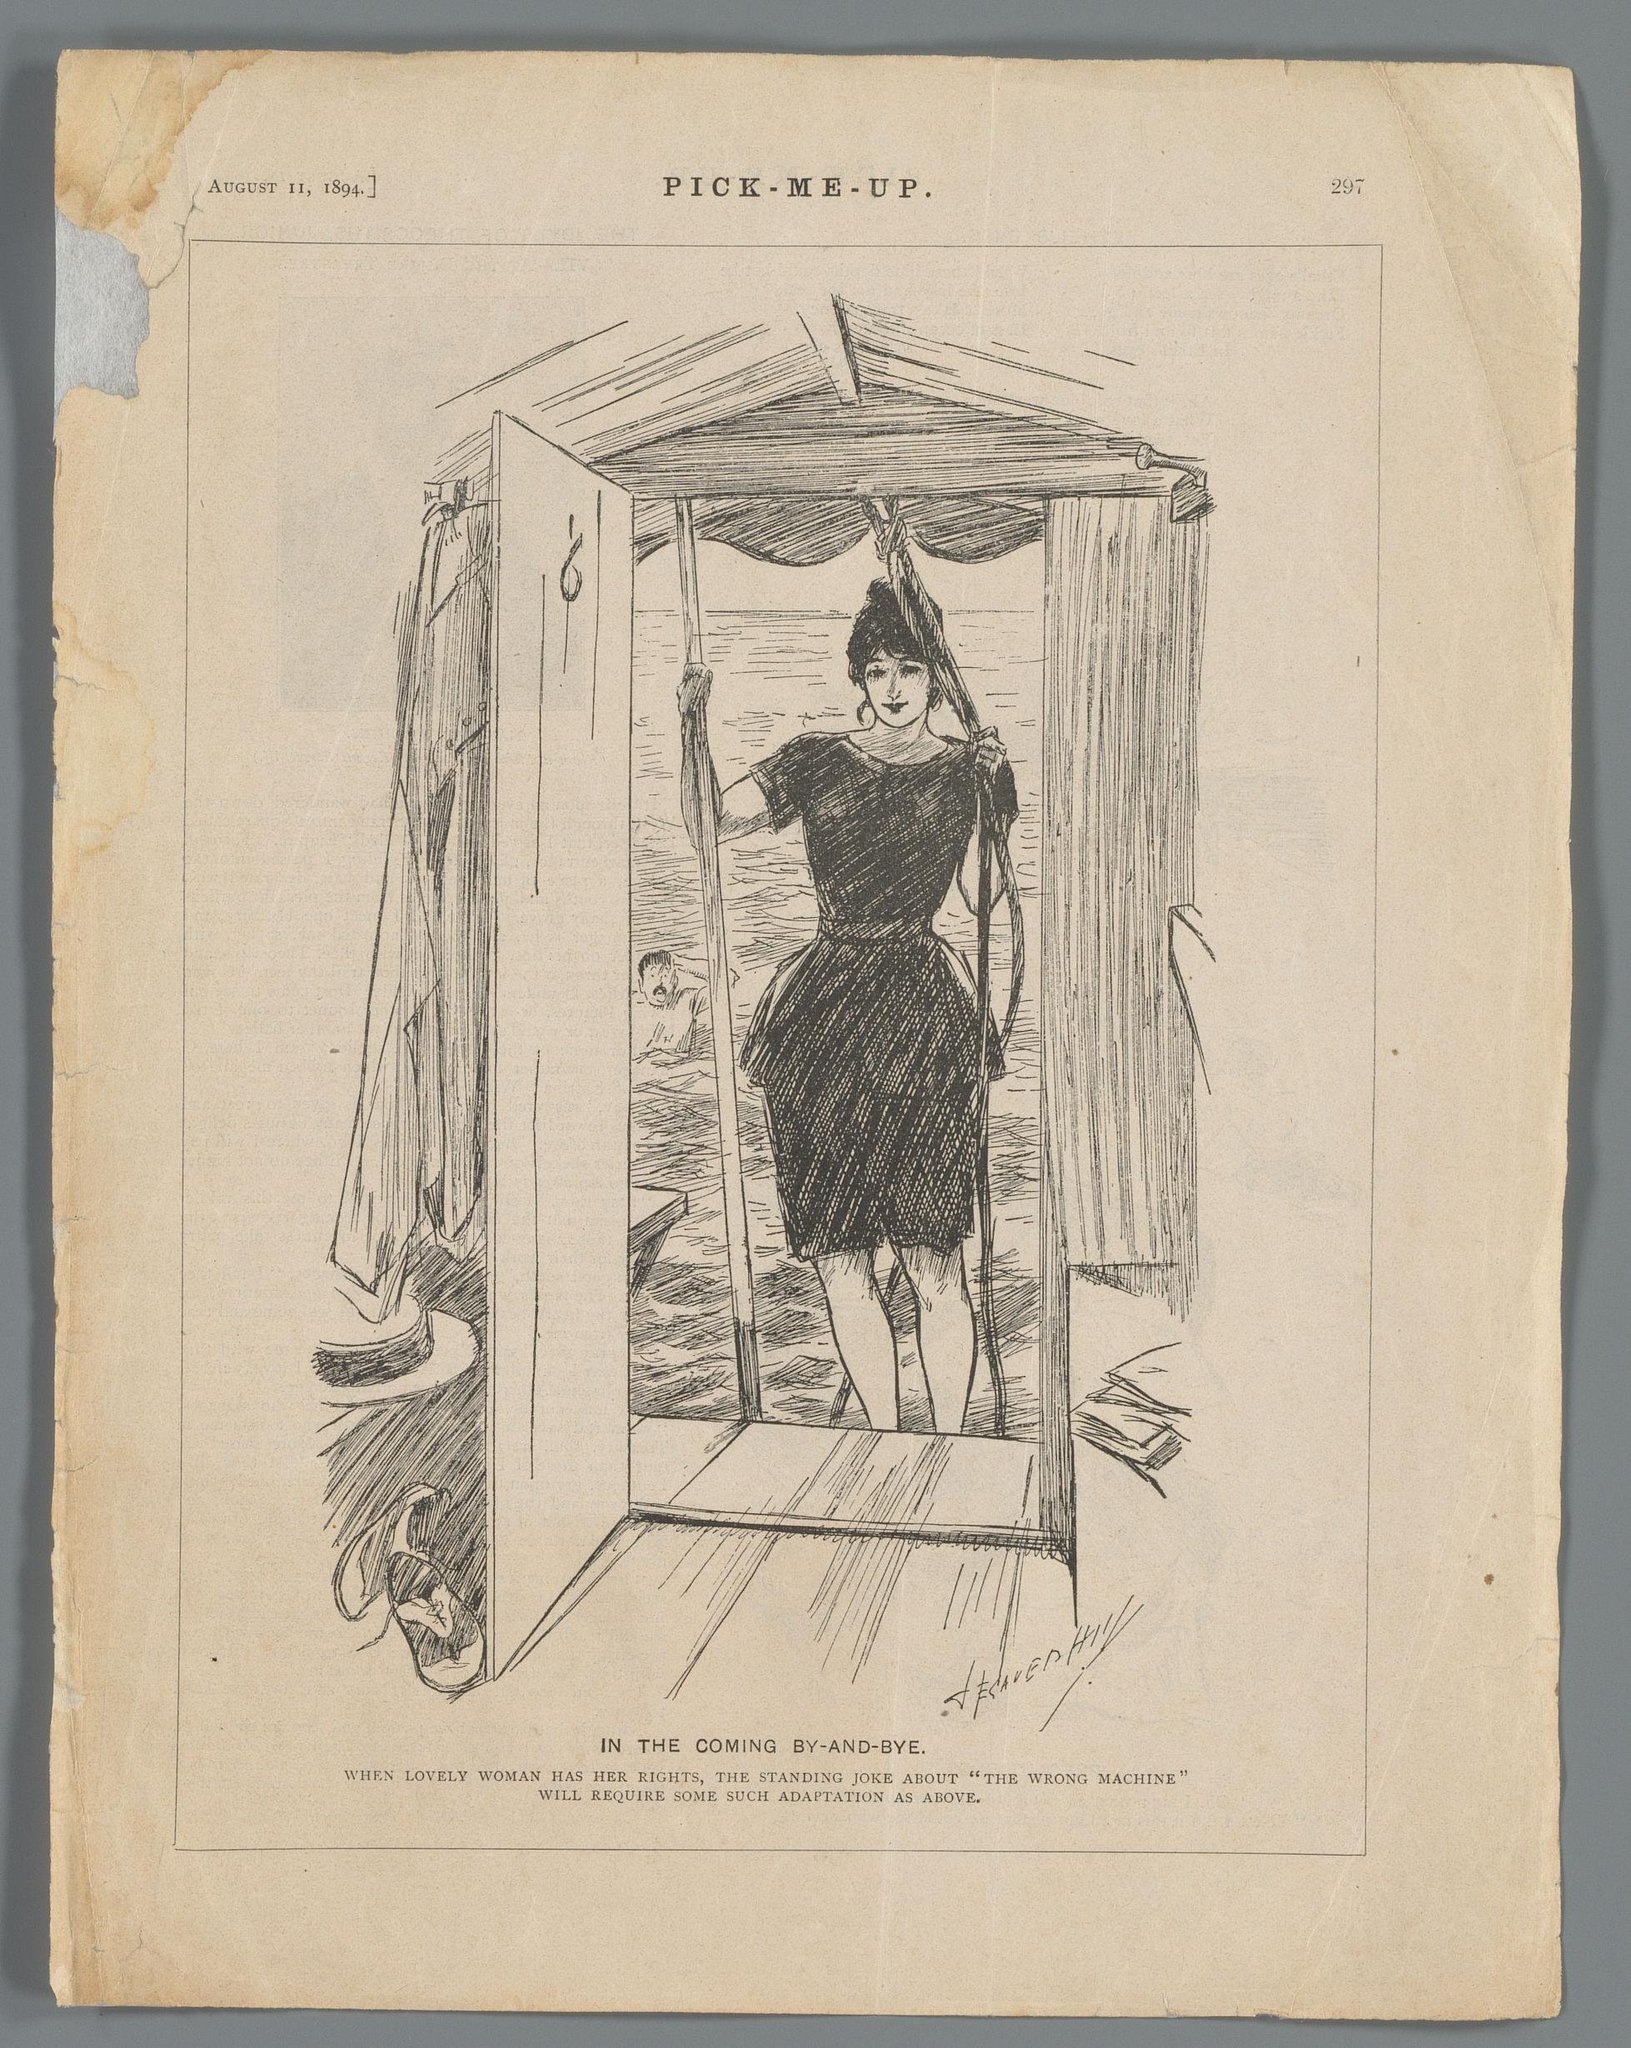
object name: print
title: Vrouw in badkleding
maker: leonard raven-hill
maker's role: draughtsman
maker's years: 1867-1942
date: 1894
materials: paper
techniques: engraving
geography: england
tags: political caricatures and satires, in or beside the water (on the beach)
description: Vrouw in badkleding stapt op het strand een verkleedwagen binnen. Spotprent op p. 297-298 uit het Engelse satirische tijdschrift Pick-me-up, 11 augustus 1894.